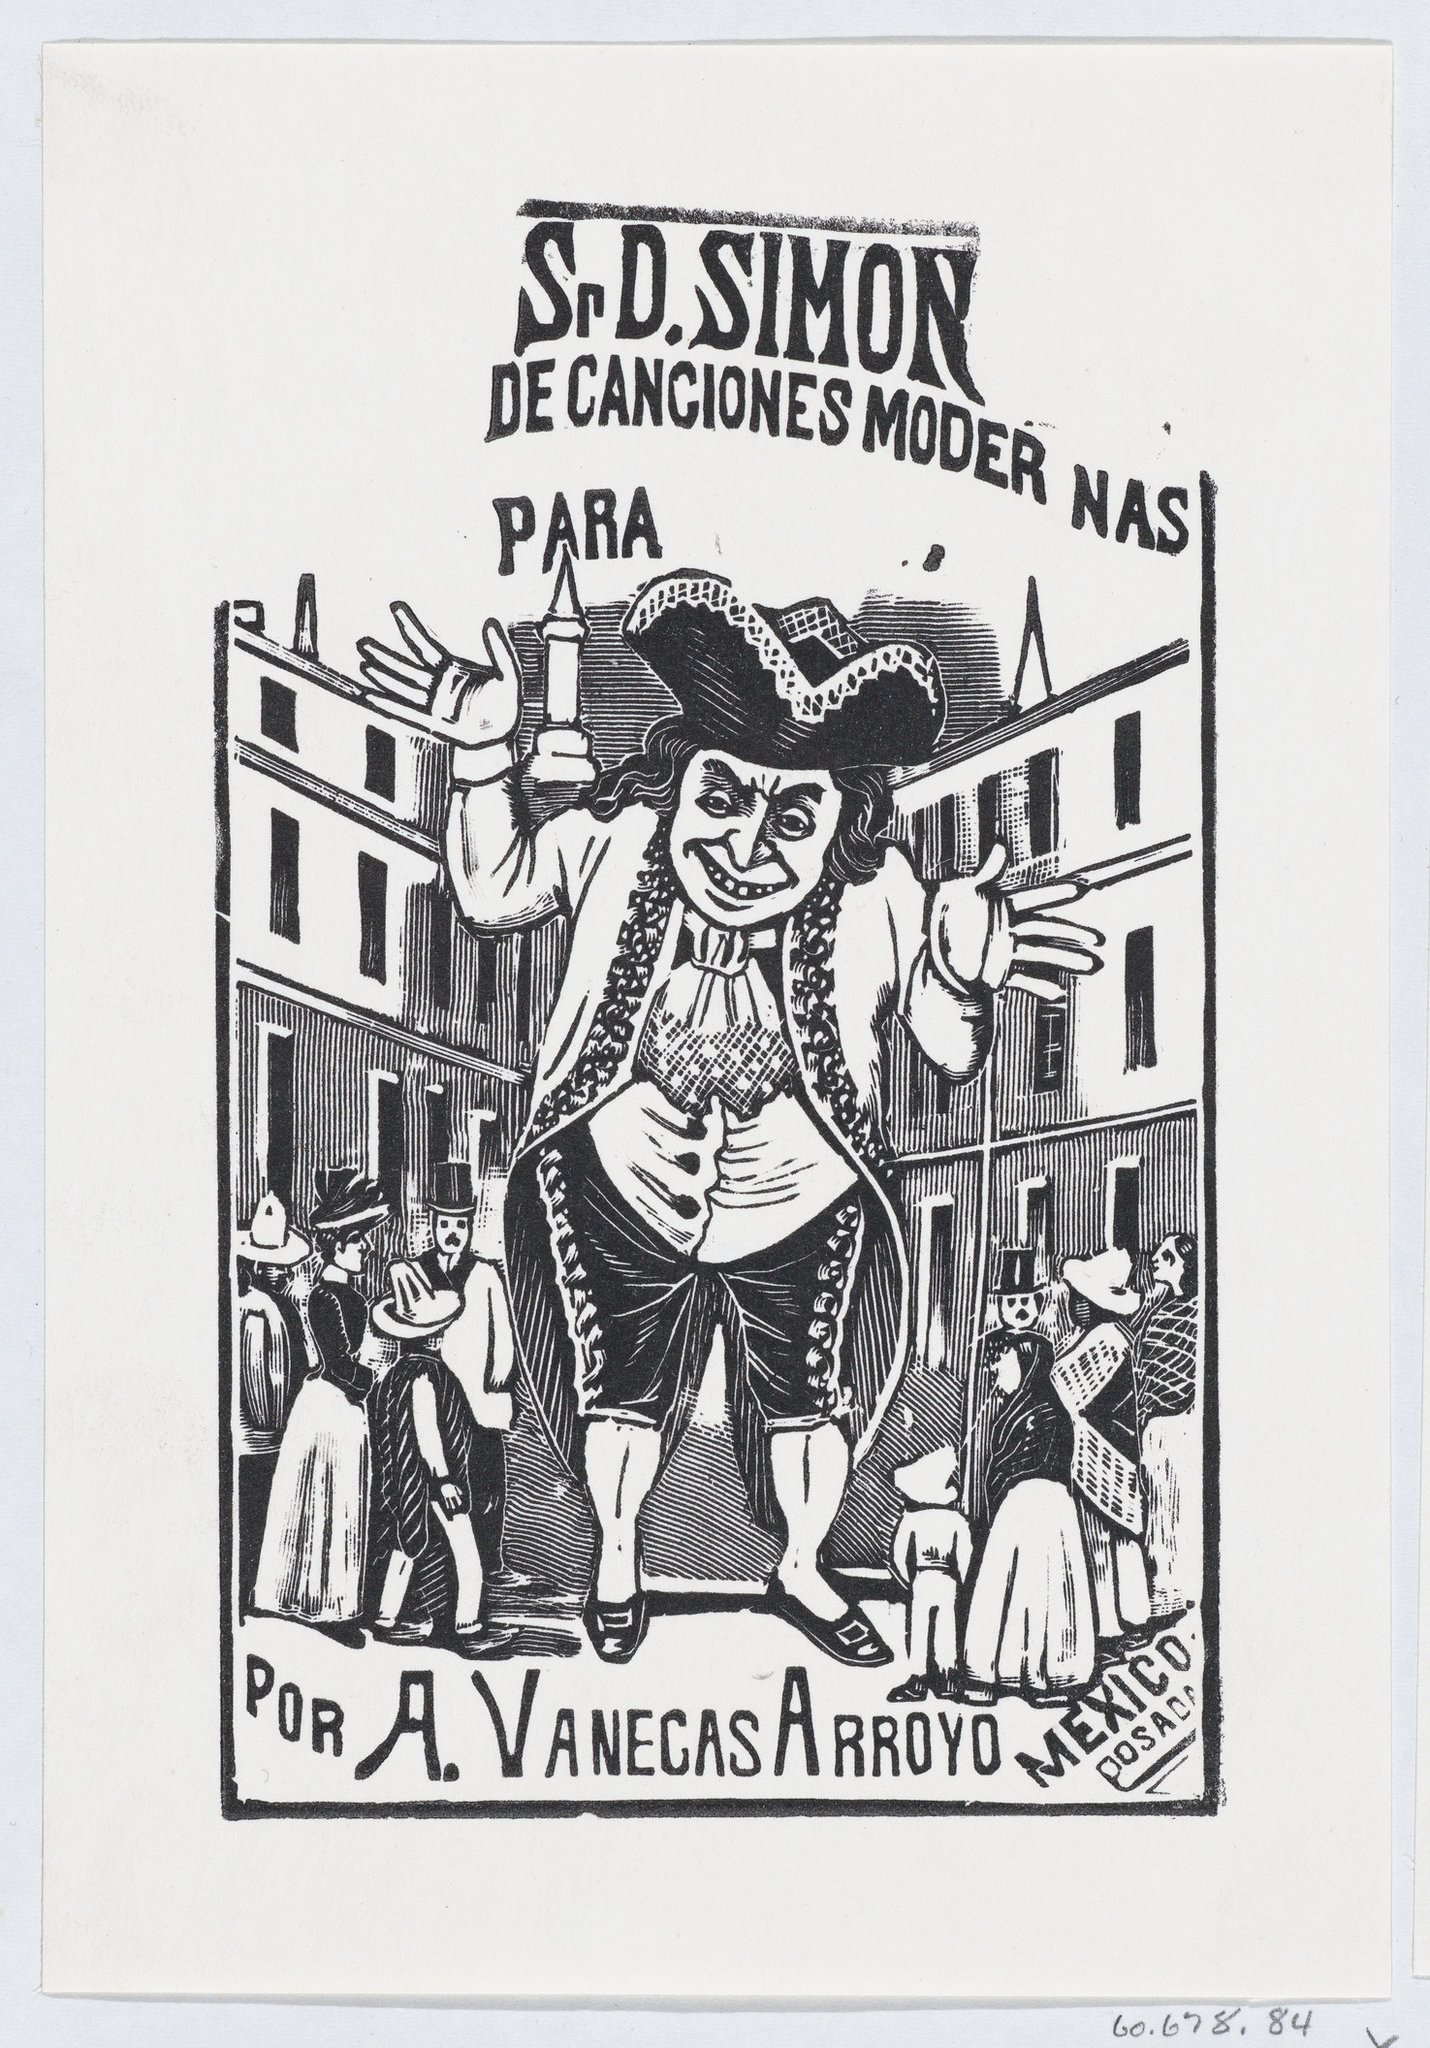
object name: print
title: A man towering over a group of people, illustration for a collection of modern songs 'Señor D. Simon'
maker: josé guadalupe posada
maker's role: artist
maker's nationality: mexican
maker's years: 1852-1913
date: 1900-1910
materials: metal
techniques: engraving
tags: men